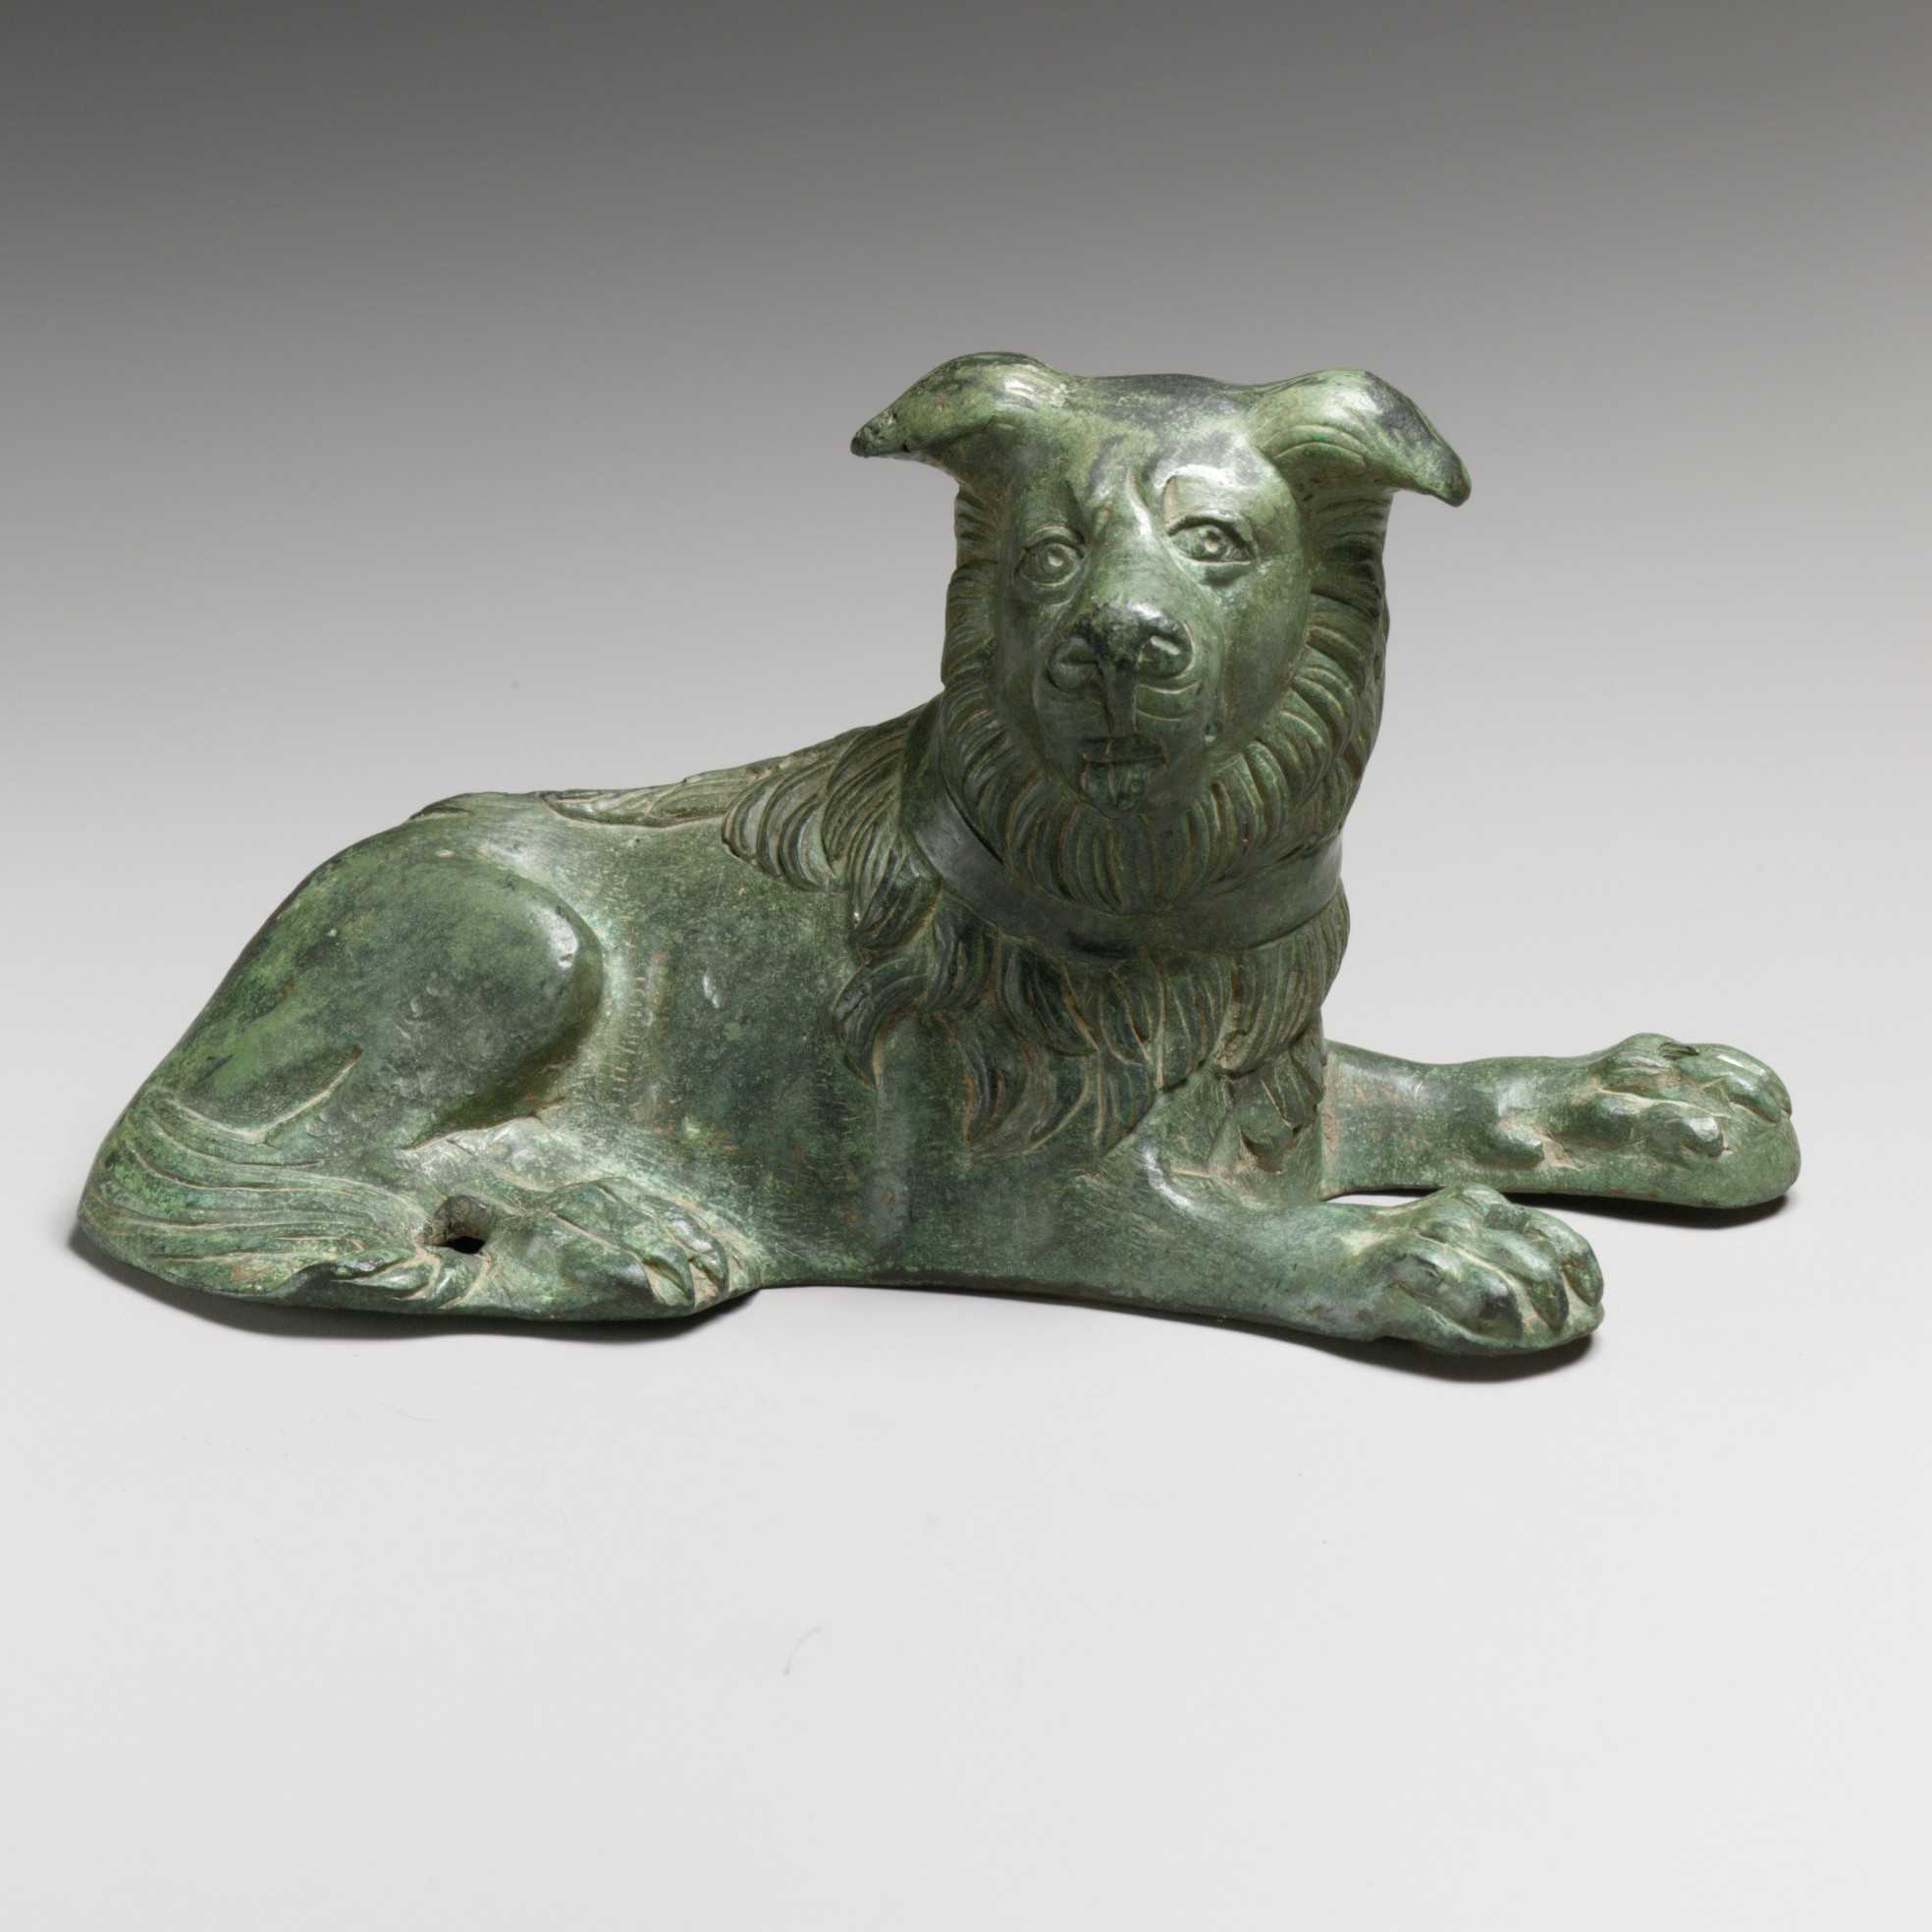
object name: statuette of a dog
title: Bronze statuette of a dog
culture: roman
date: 101-300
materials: bronze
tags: dogs